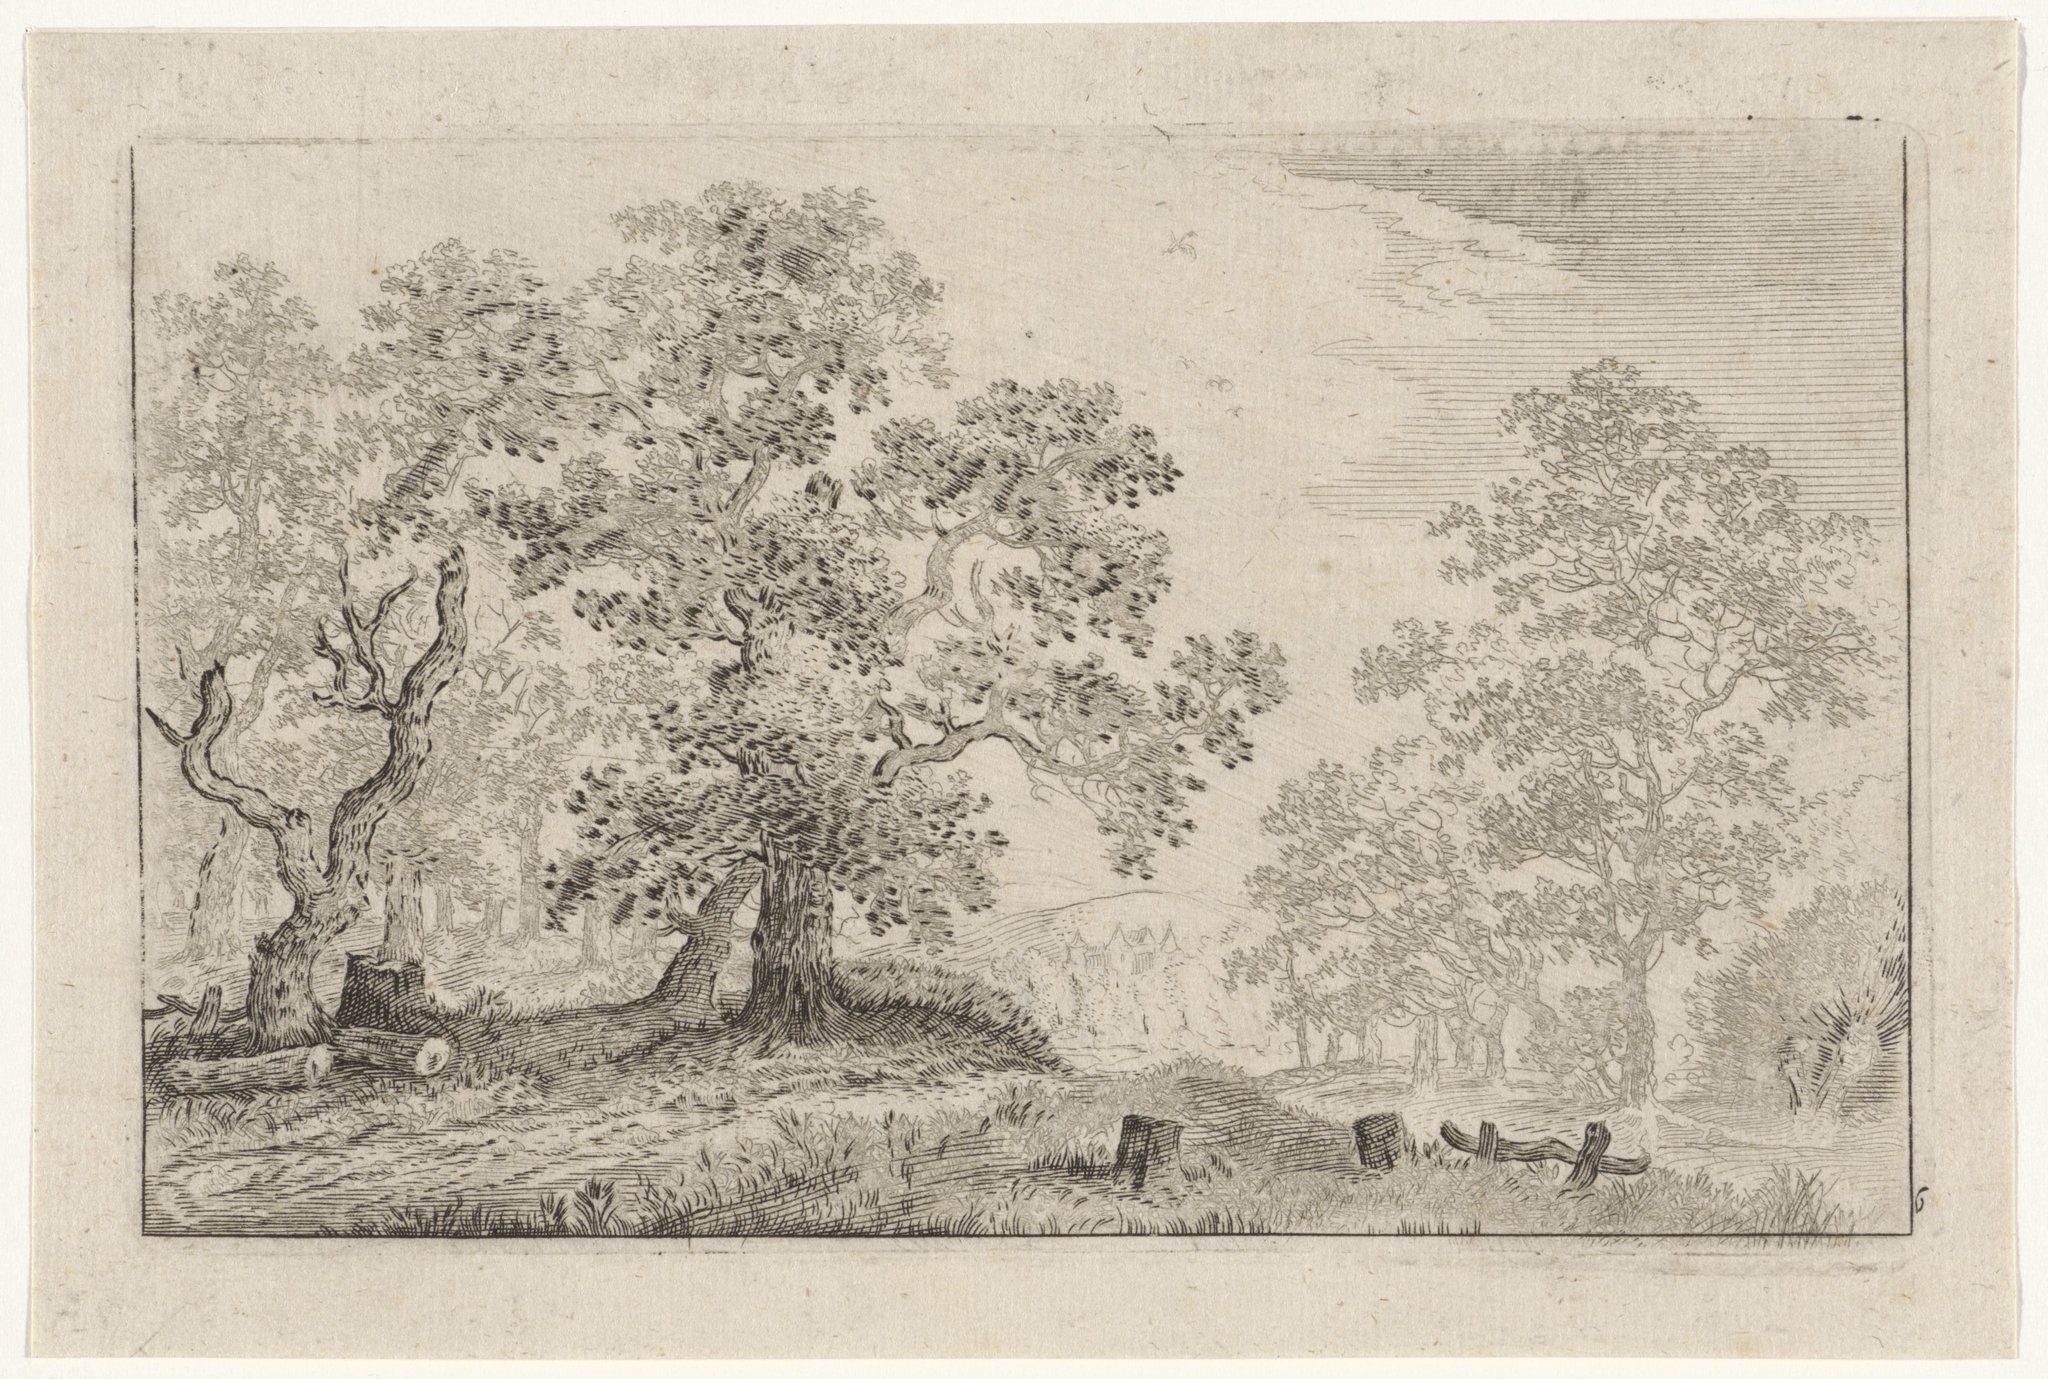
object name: print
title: Landschap met in de verte een kasteel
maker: jean vaillant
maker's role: print maker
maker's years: 1627-1668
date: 1637-1674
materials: paper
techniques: etching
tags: landscape with tower or castle, forest path or lane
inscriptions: collector's mark: Lugt 2288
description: Landschap met bomen en in de verte een kasteel. Zesde prent uit een serie van zes prenten met landschappen.